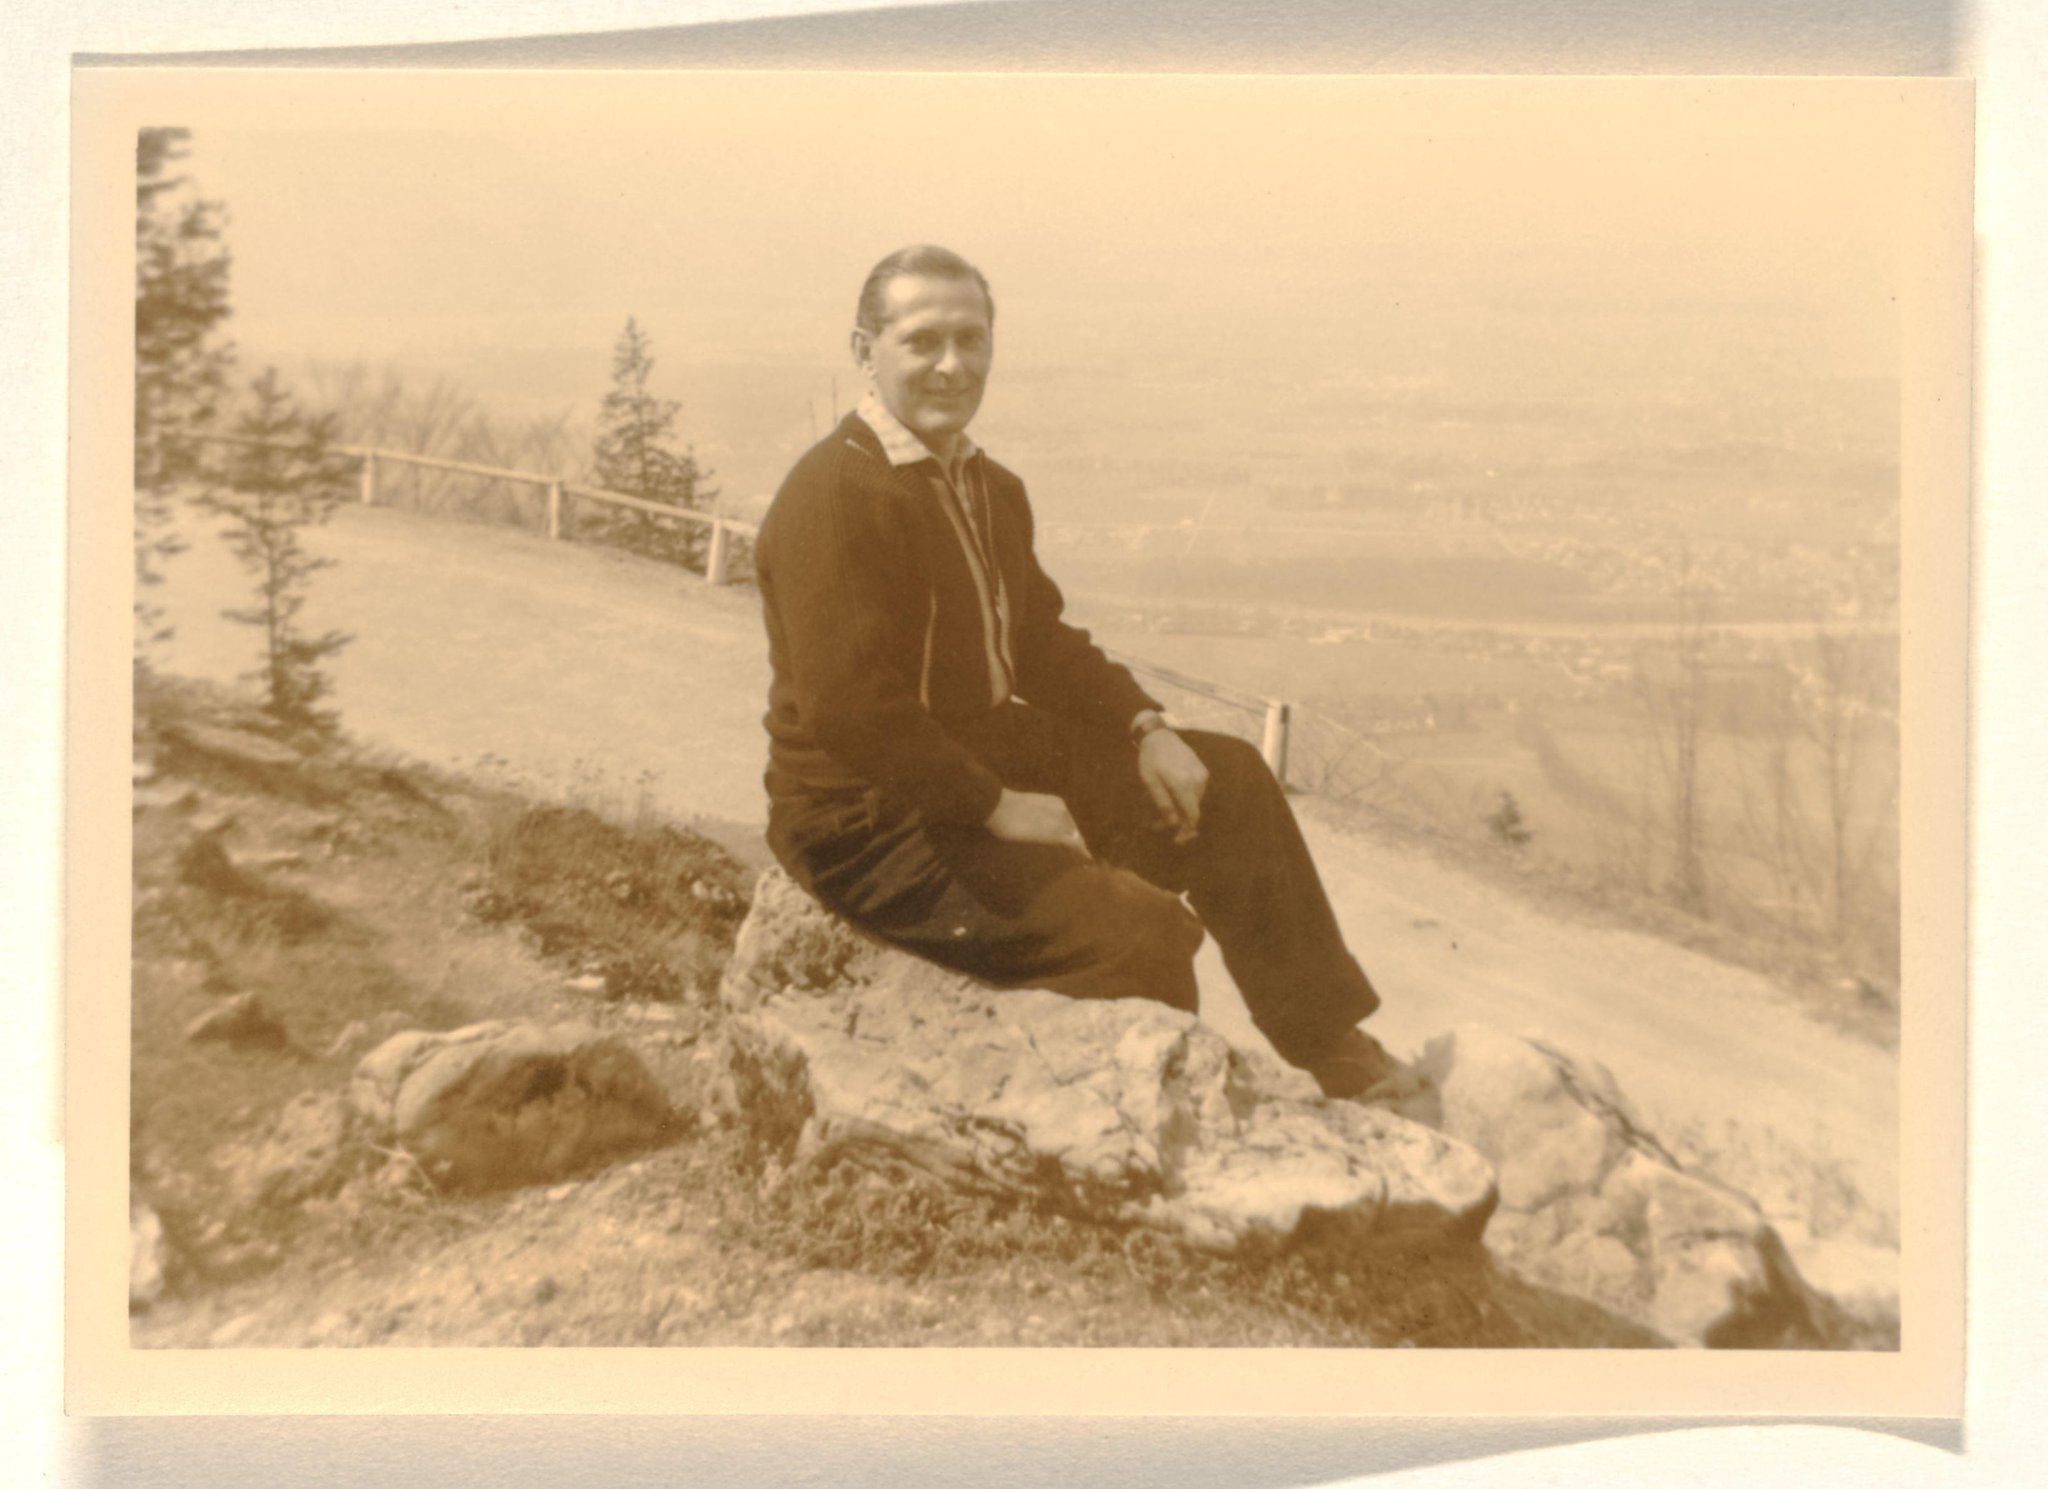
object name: photograph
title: Gideon Elon, de derde echtgenoot van Isabel Wachenheimer, gezeten op een steen tijdens de huwelijksreis van Isabel en Gideon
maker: Anonymous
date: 1956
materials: photographic support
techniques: gelatin silver print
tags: gideon elon, wedding trip, honeymoon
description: Gideon Elon, de derde echtgenoot van Isabel Wachenheimer, gezeten op een steen,